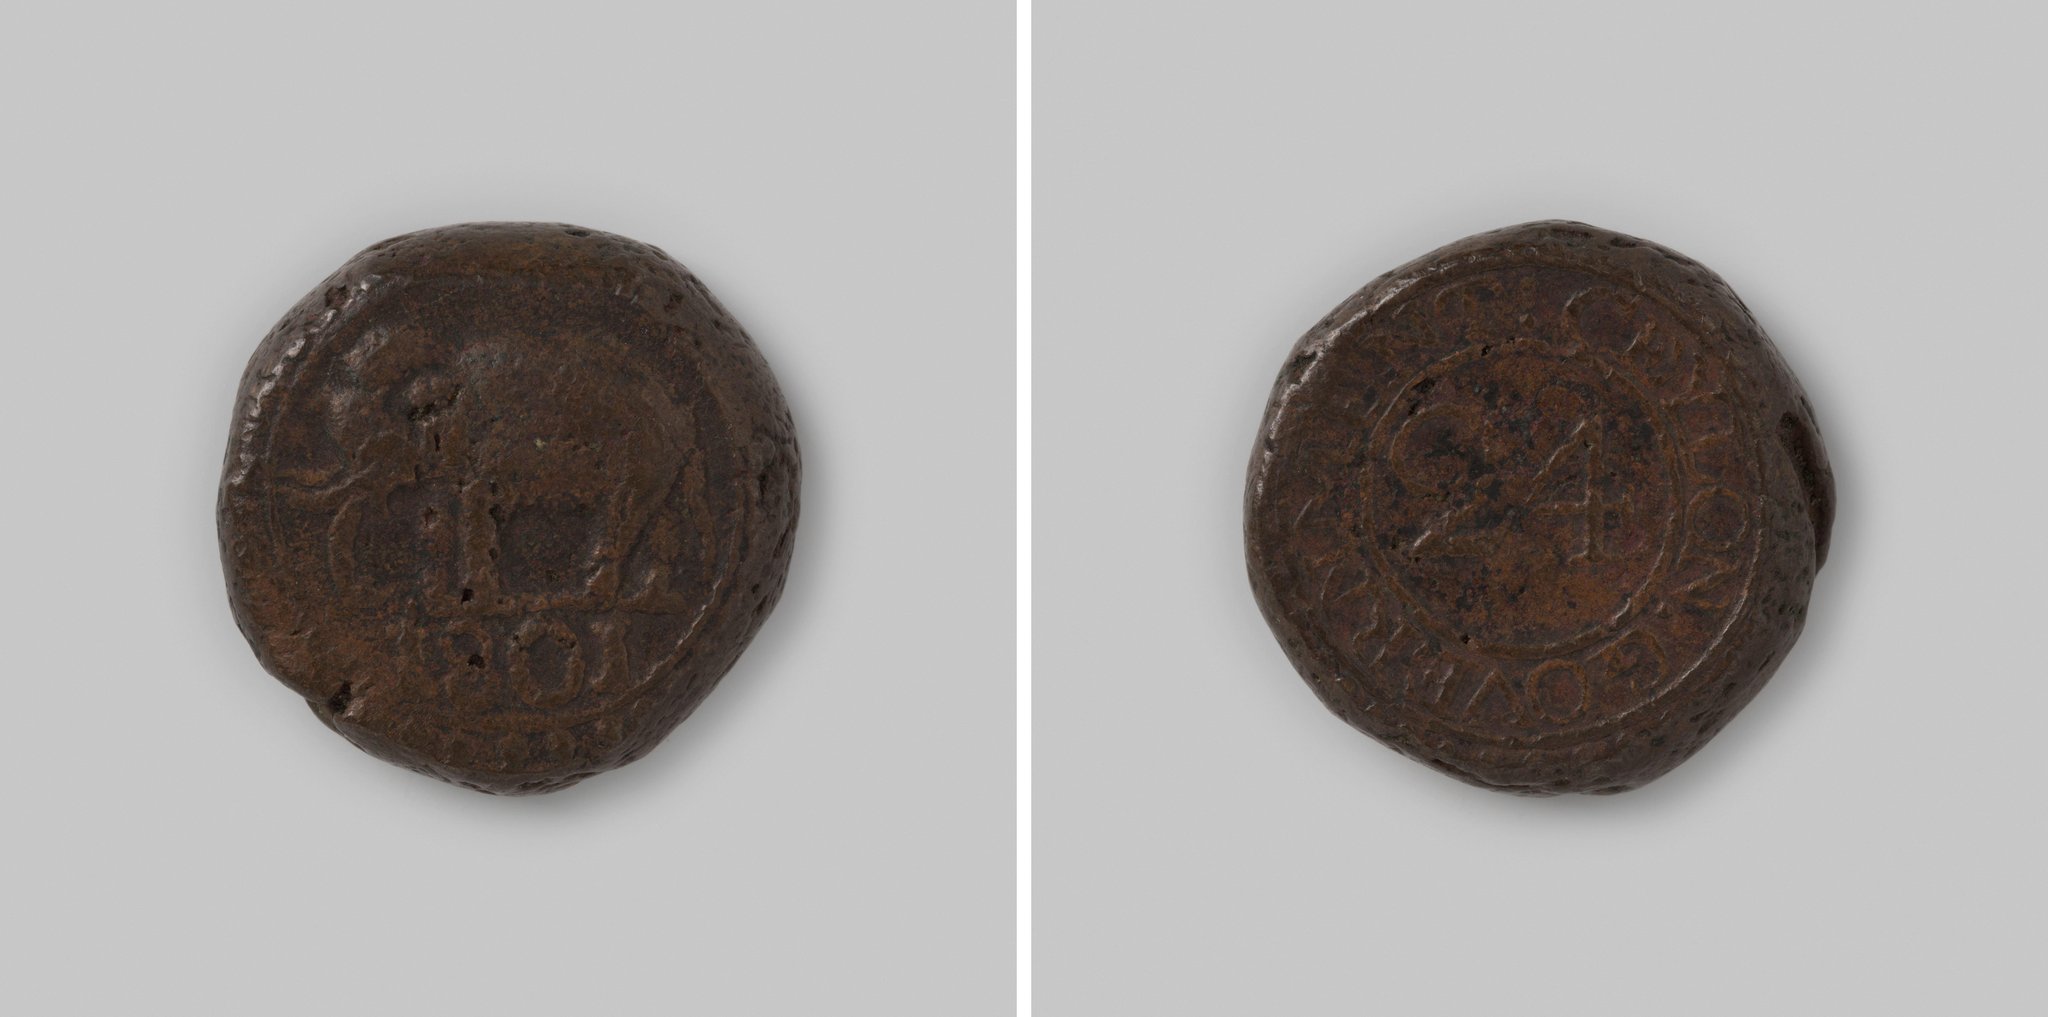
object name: coin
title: Sri Lanka, Ceylon, 24 stivers, 1801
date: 1801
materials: copper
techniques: striking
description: Koperen munt. Voorzijde: lopende olifant naar links. In afsnede jaartal onderaan. Keerzijde: binnen cirkel van stippen waarde-aanduiding: 24 [=1/24 rixdollar]. Geslagen in Ceylon.